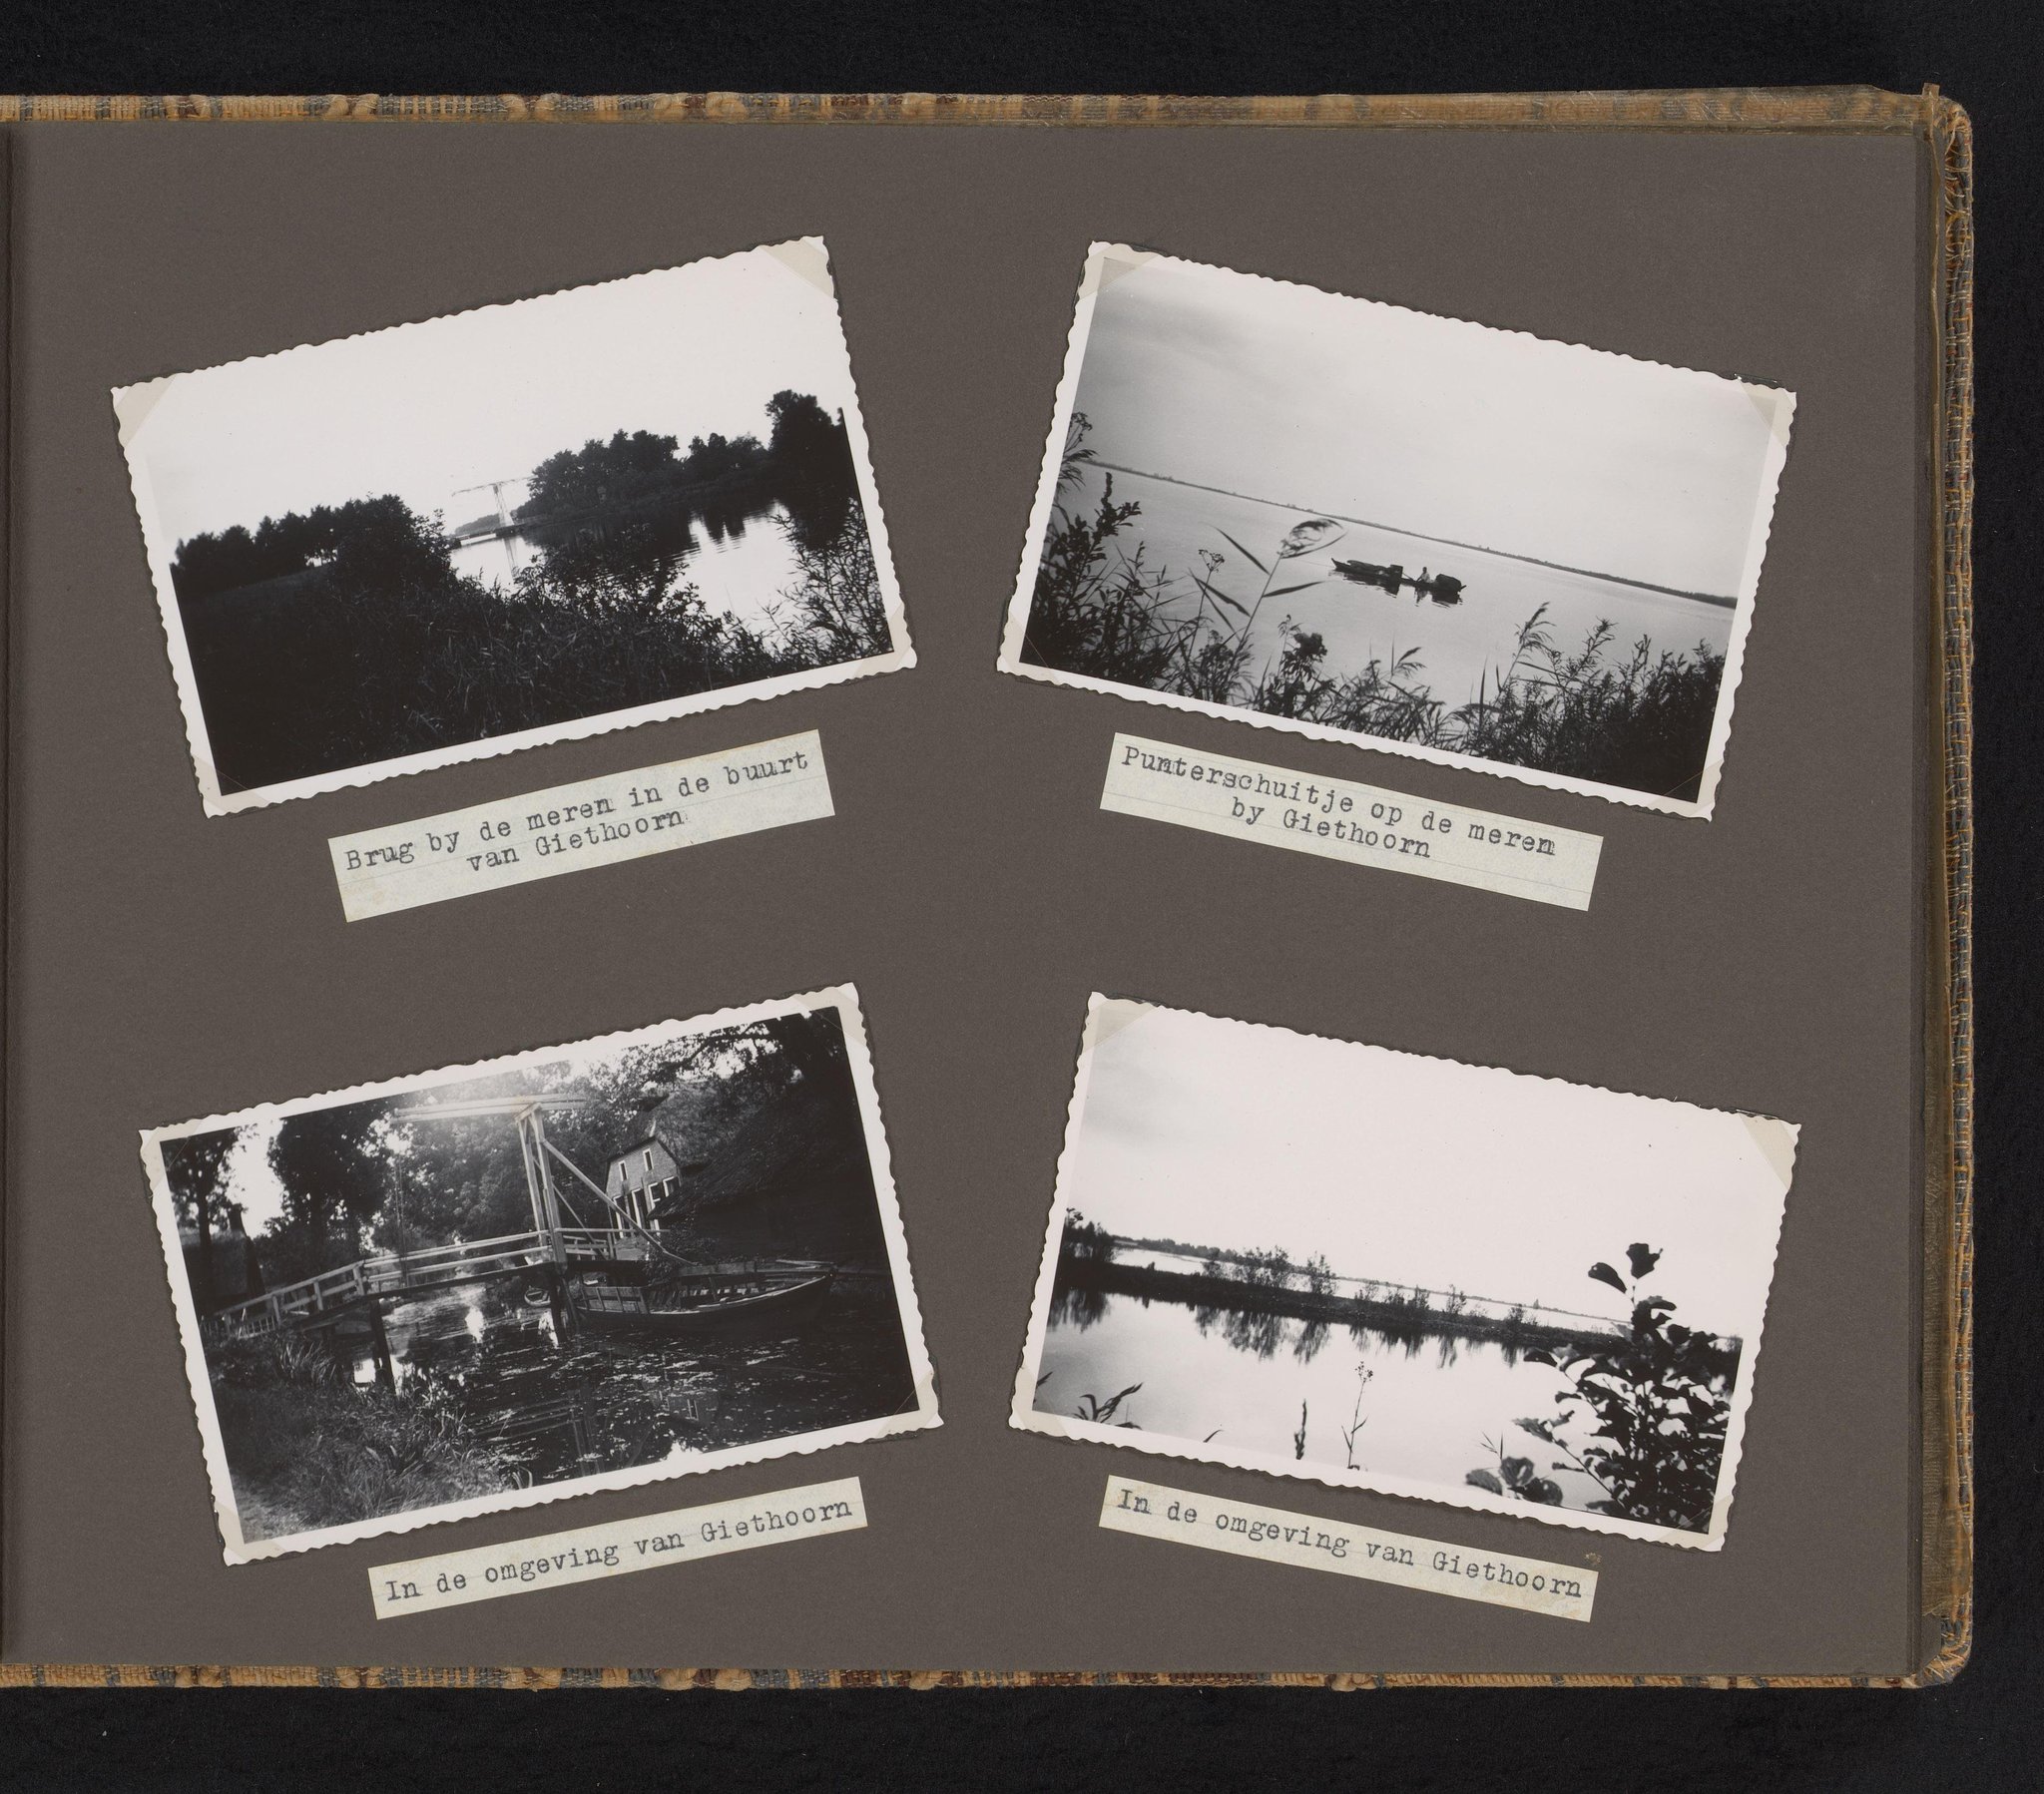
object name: album leaf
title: Giethoorn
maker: Anonymous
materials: paper, photographic support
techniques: gelatin silver print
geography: netherlands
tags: riding, cycling (recreation), lake, father with son(s) (father-love), outing, pleasure trip, bicycle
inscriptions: inscription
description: Albumblad met vier foto's in de omgeving van Giethoorn. Onder de foto's uitgeknipte papiertjes met getypte opschriften. Onderdeel van het eerste fotoalbum met foto's van de twee fietstochten van vader en zoon door Nederland in september 1939 en juli 1940 en een autotrip met het gezin door Nederland, België en Luxemburg in juni 1949.